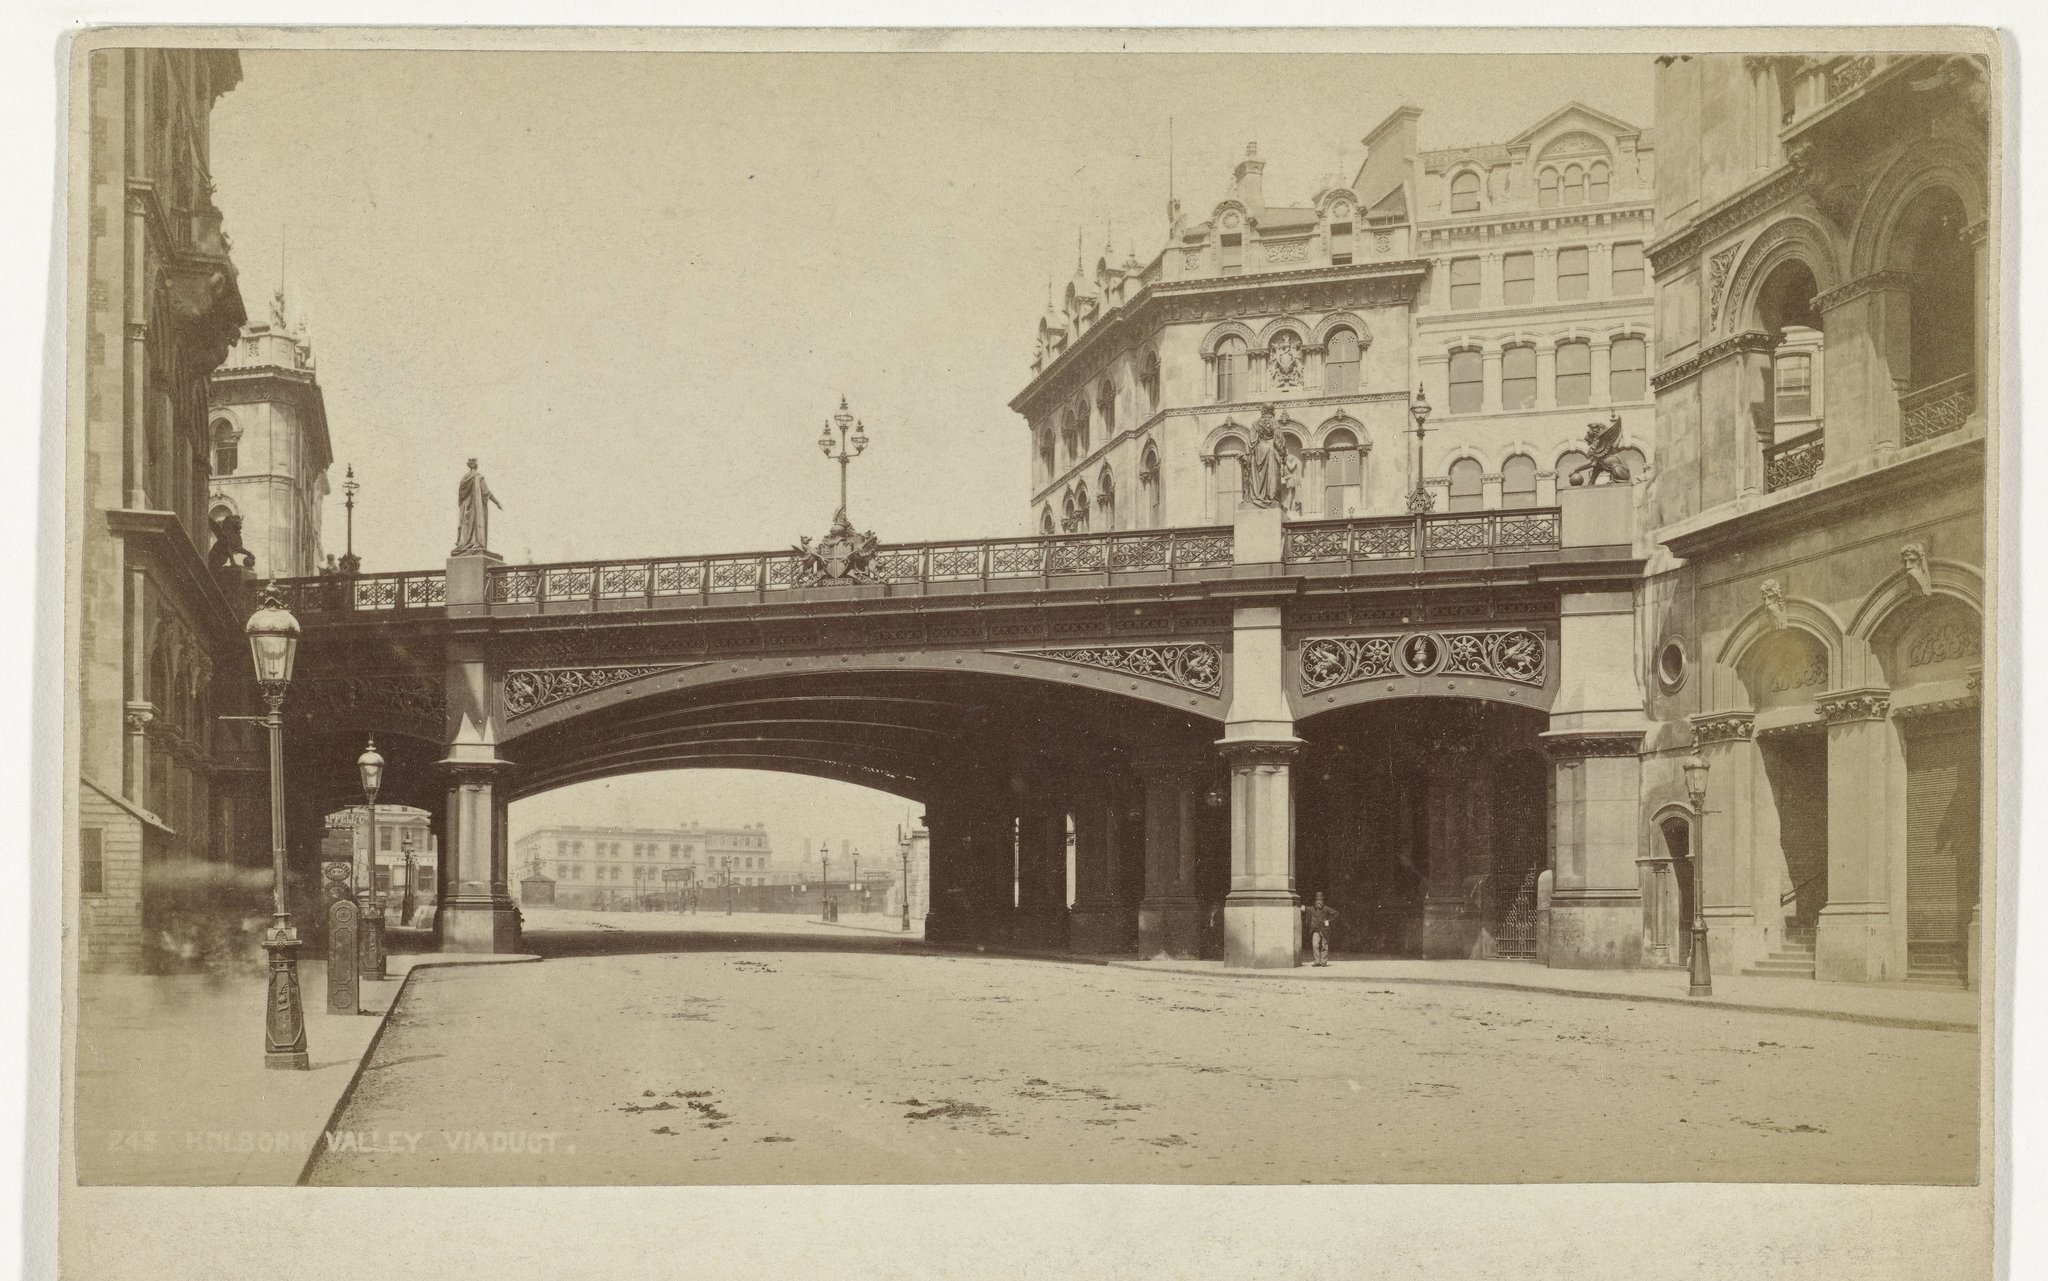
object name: photograph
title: Holborn Valley Viaduct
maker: Anonymous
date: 1869-1900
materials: cardboard, paper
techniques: albumen print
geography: holborn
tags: viaduct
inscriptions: number: ‘245’